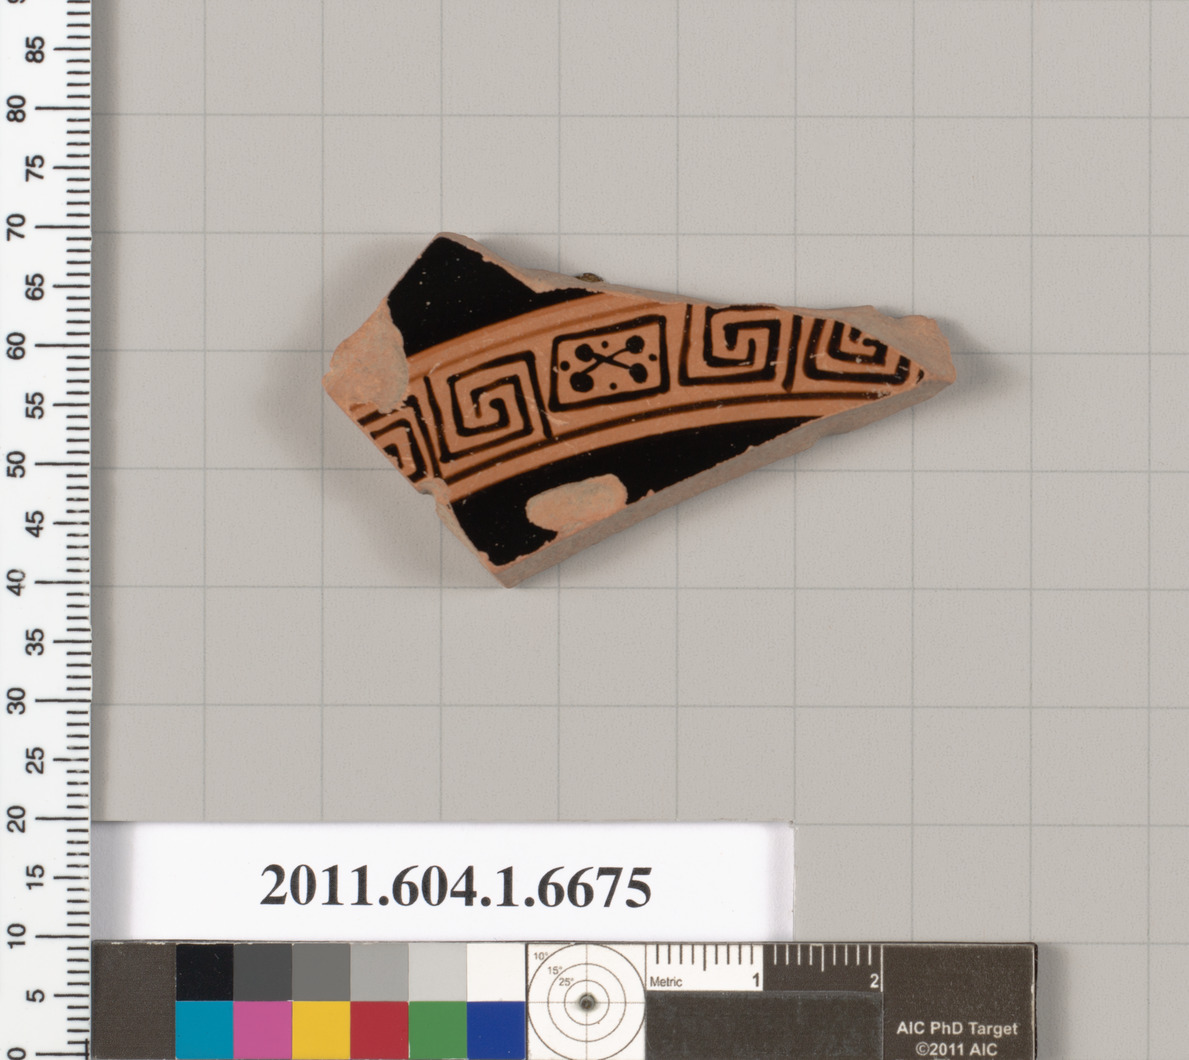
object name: kylix fragment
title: Terracotta fragment of a kylix (drinking cup)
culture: greek, attic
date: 490-470 BCE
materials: terracotta